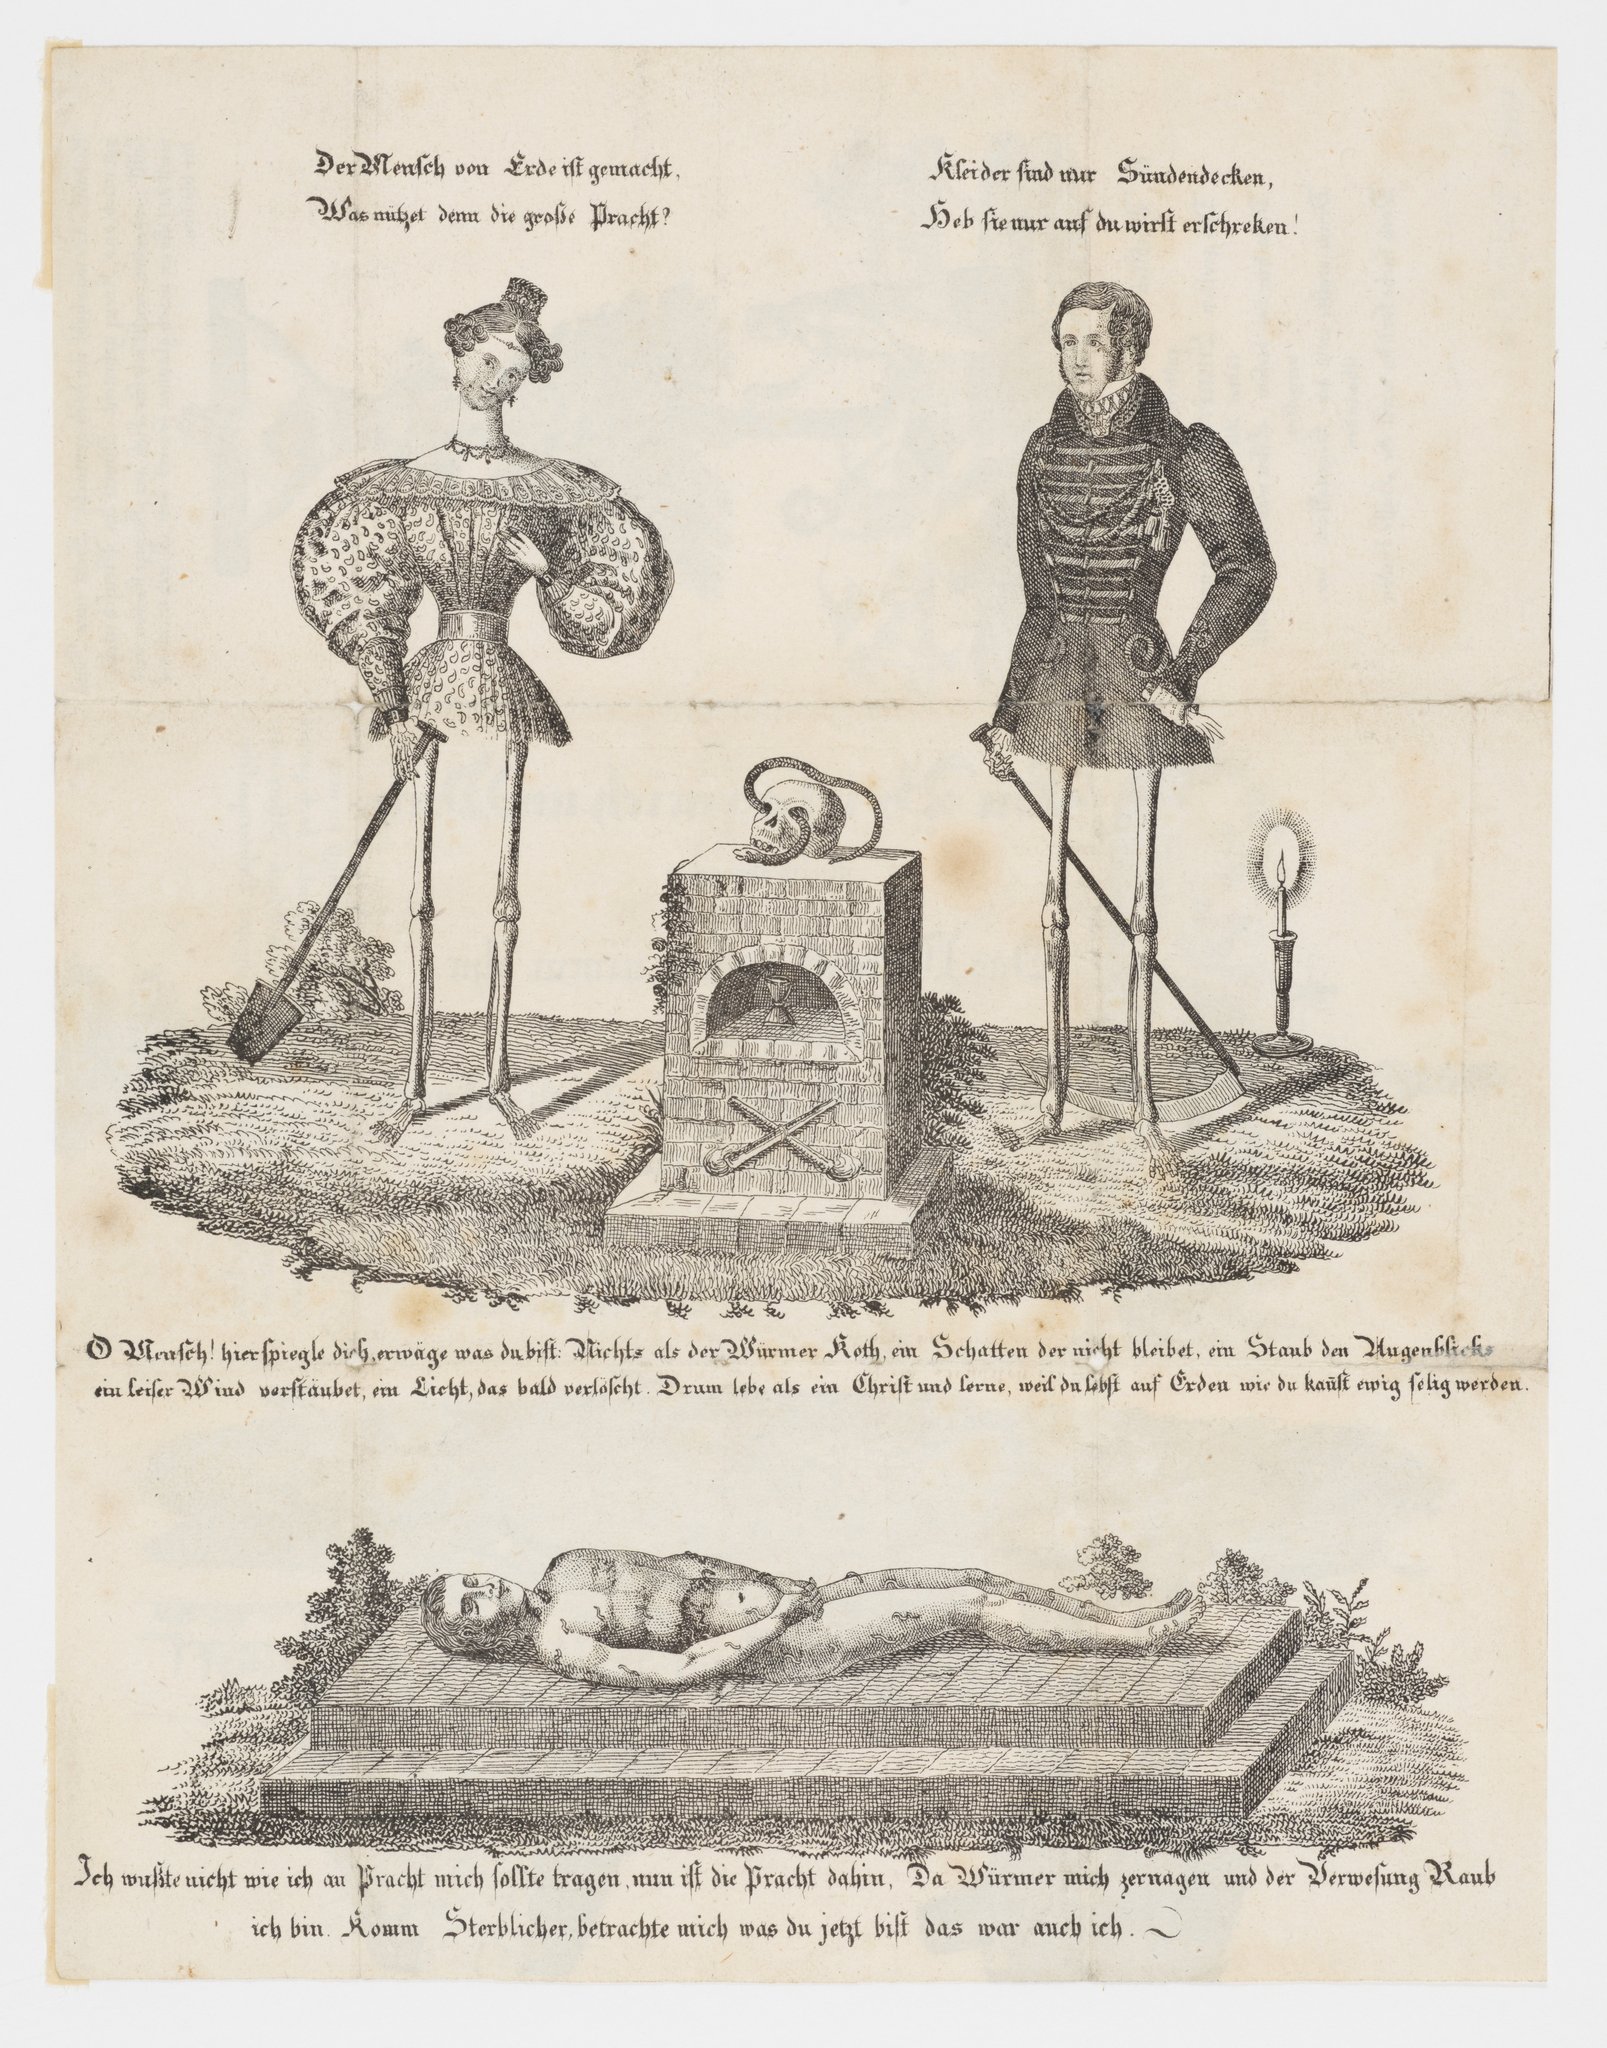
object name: print, ephemera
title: A Letter to Me and You (Memento Mori)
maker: anonymous, german, 19th century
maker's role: artist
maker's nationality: german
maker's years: 1800-1899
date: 1860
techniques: lithograph